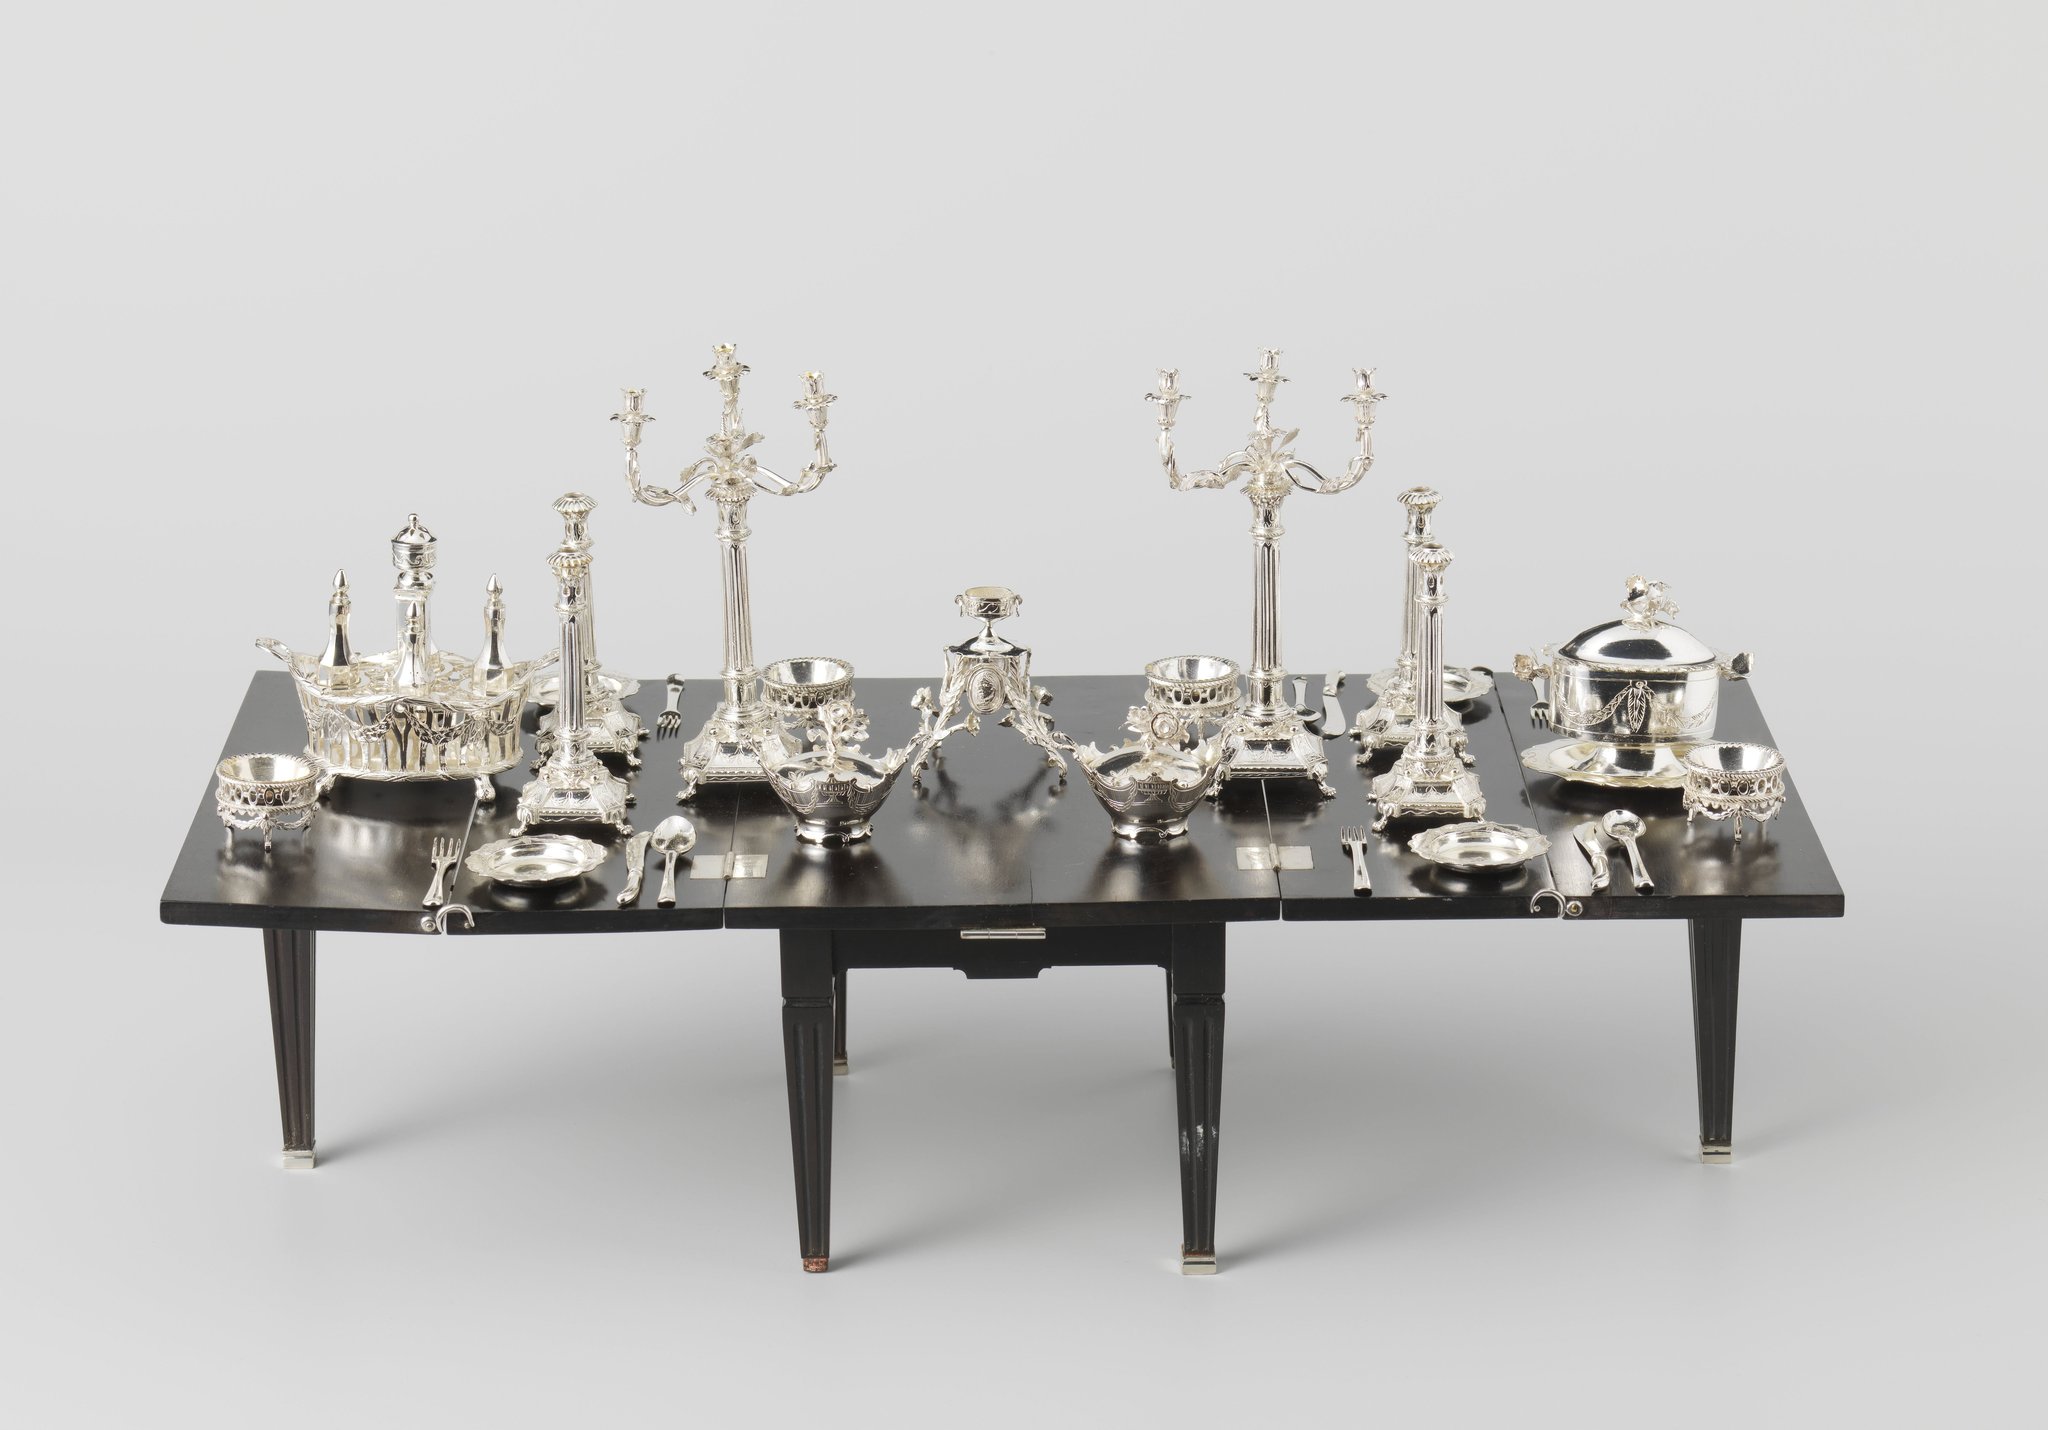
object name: miniature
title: Fles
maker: hendrik duller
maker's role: silversmith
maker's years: 1749-1820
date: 1784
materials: silver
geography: amsterdam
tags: container of glass: bottle, jar, vase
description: Fles behorend tot een olie- en azijnstel (BK-NM-11177-122). De fles is achthoekig en heeft een lange, smalle hals. De fles heeft een schenktuit en een knopvormige deksel. De fles staat samen met drie identieke flessen (BK-NM-11177-122-c, BK-NM-11177-122-d, BK-NM-11177-122-f) op een plateau (BK-NM-11177-122-b) in een mand (BK-NM-11177-122-a).